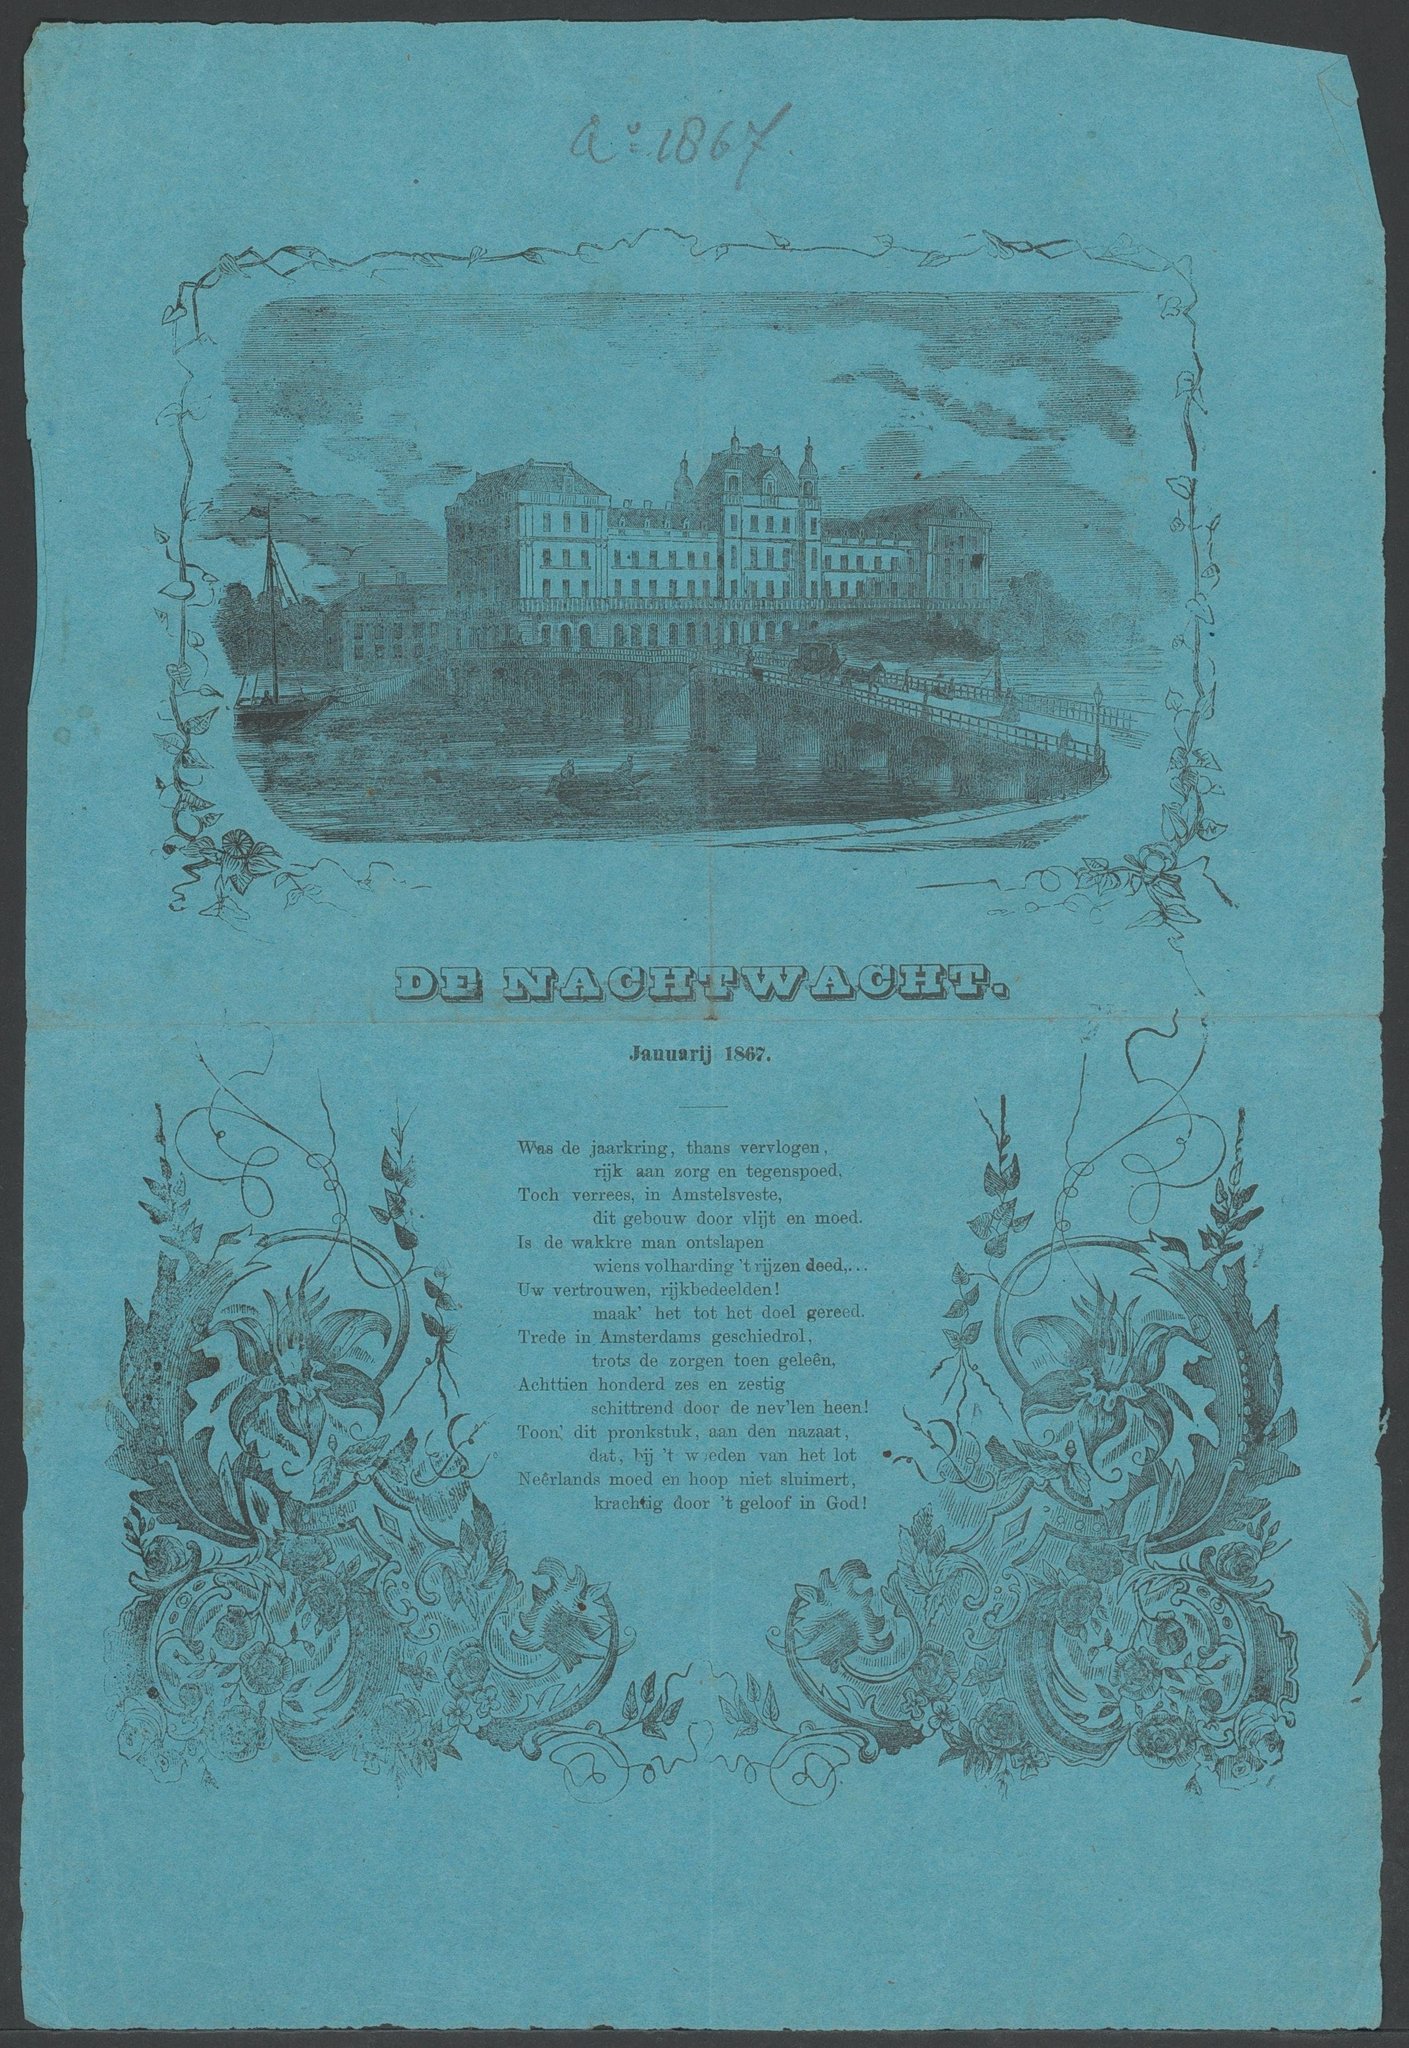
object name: print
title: Nieuwjaarswens van de Amsterdamse nachtwacht voor het jaar 1867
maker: Anonymous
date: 1866-1867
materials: paper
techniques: letterpress printing, engraving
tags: night patrol, hotel, hostelry, inn, amsterdam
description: Nieuwjaarswens van de Amsterdamse nachtwacht (ratelwacht) voor het jaar 1867. Onderaan een gedicht, bovenaan een gezicht op het Amstelhotel. Onderwerpsrubrieken binnen de Atlas Zeden en Gewoonten: Zeden en gewoonten in engeren zin, Volksleven, Volksbladen, Nieuwjaars- en Kerstwenschen, Amsterdam.